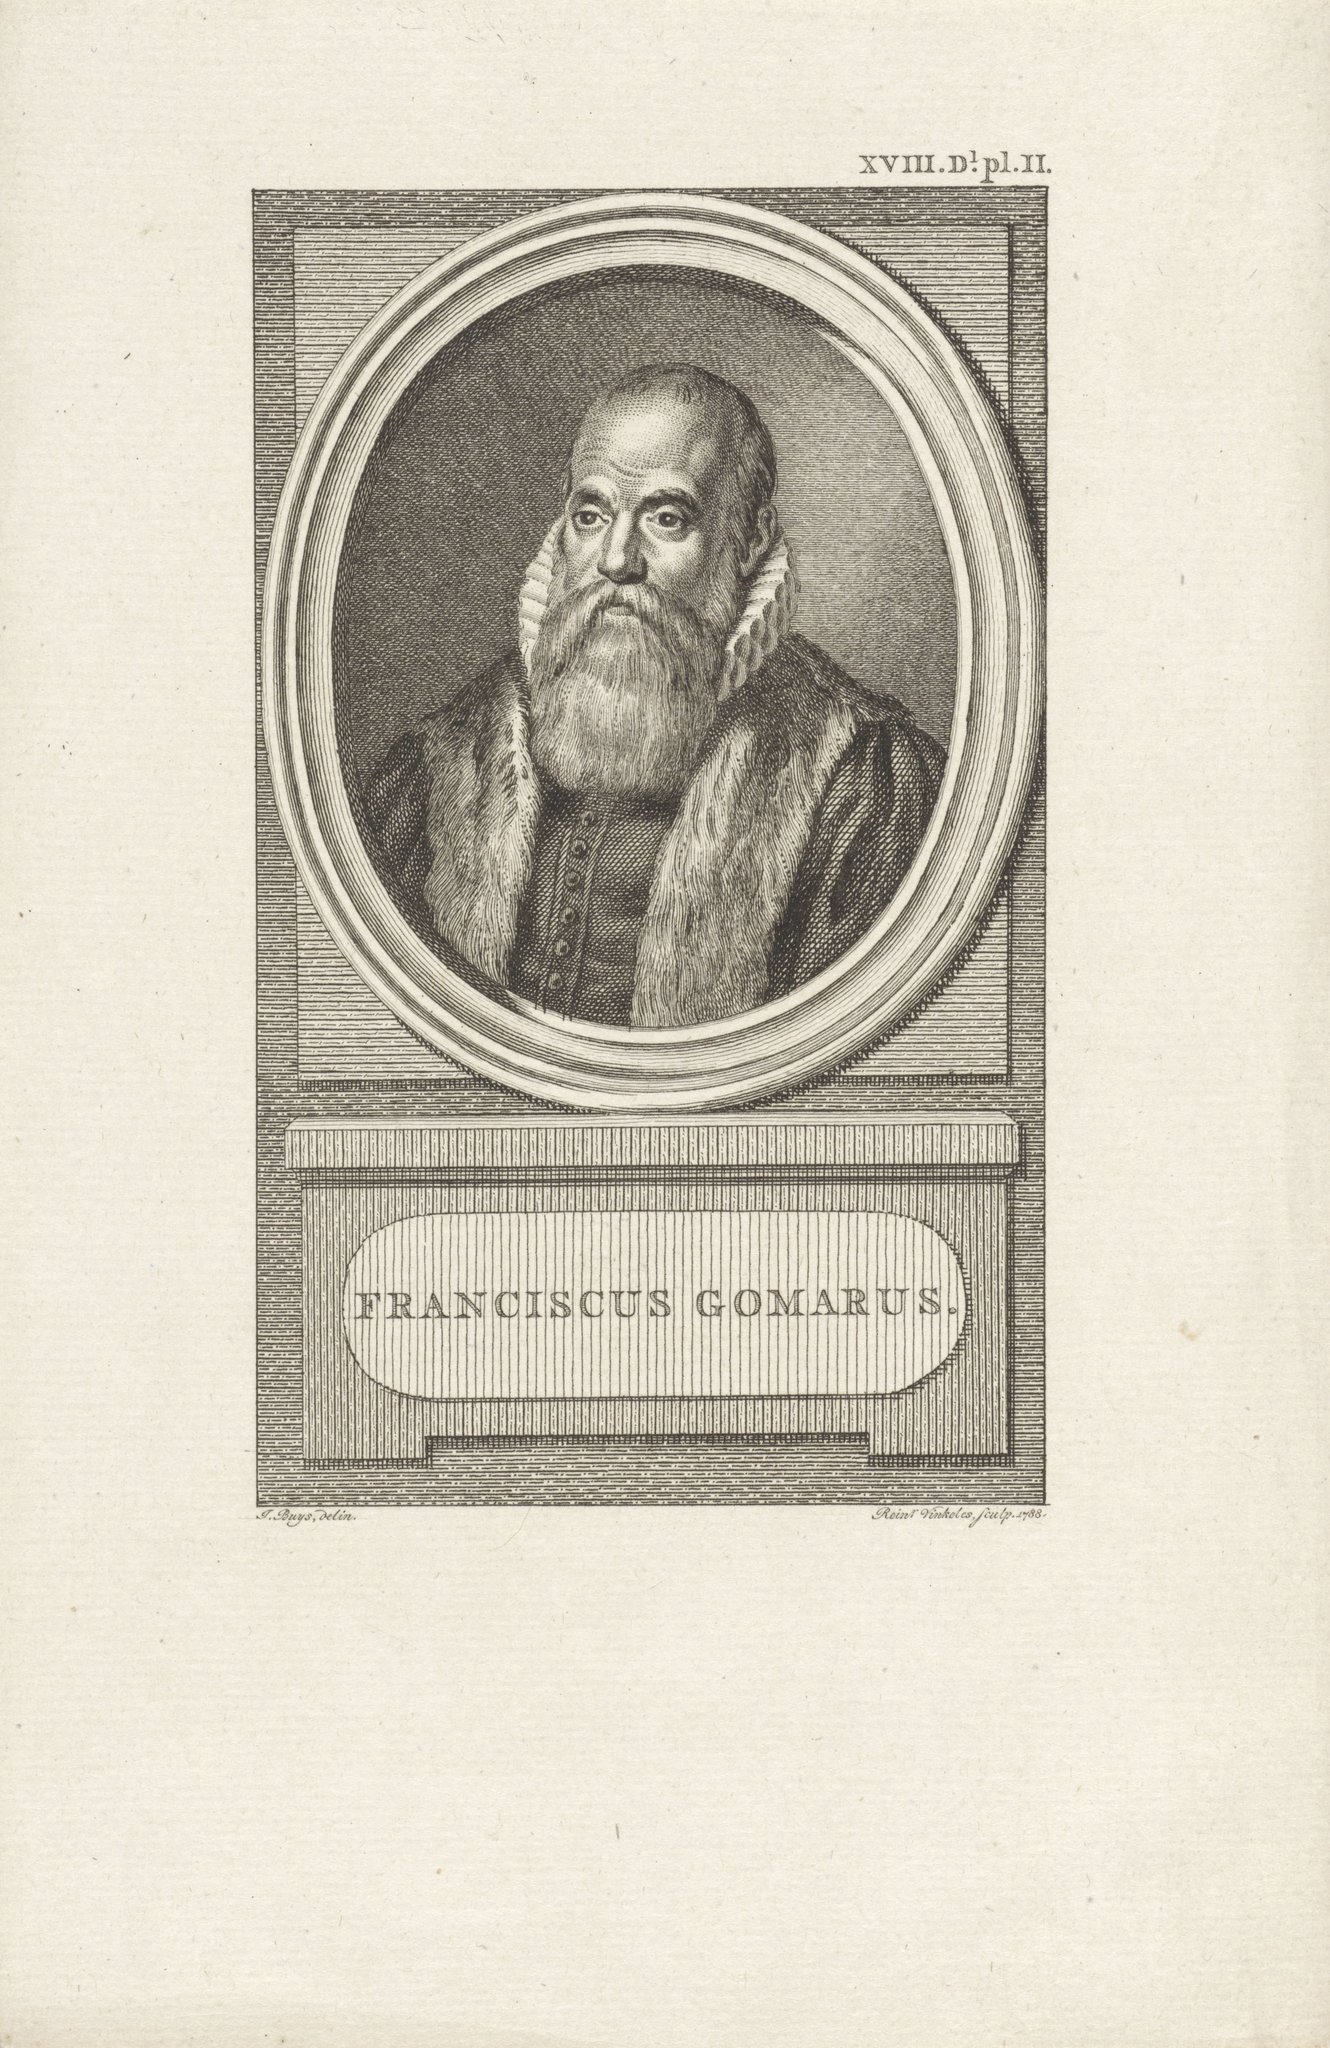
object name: book illustration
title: Portret van de theoloog Franciscus Gomarus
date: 1788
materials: paper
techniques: etching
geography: amsterdam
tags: bruges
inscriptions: collector's mark: Lugt 2228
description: Prent gebruikt als boekillustratie in: Kok, Jacobus. Vaderlandsch woordenboek : met kaarten, plaaten en pourtraitten. Amsterdam: Johannes Allart, 1785-1796. Deel XVIII.